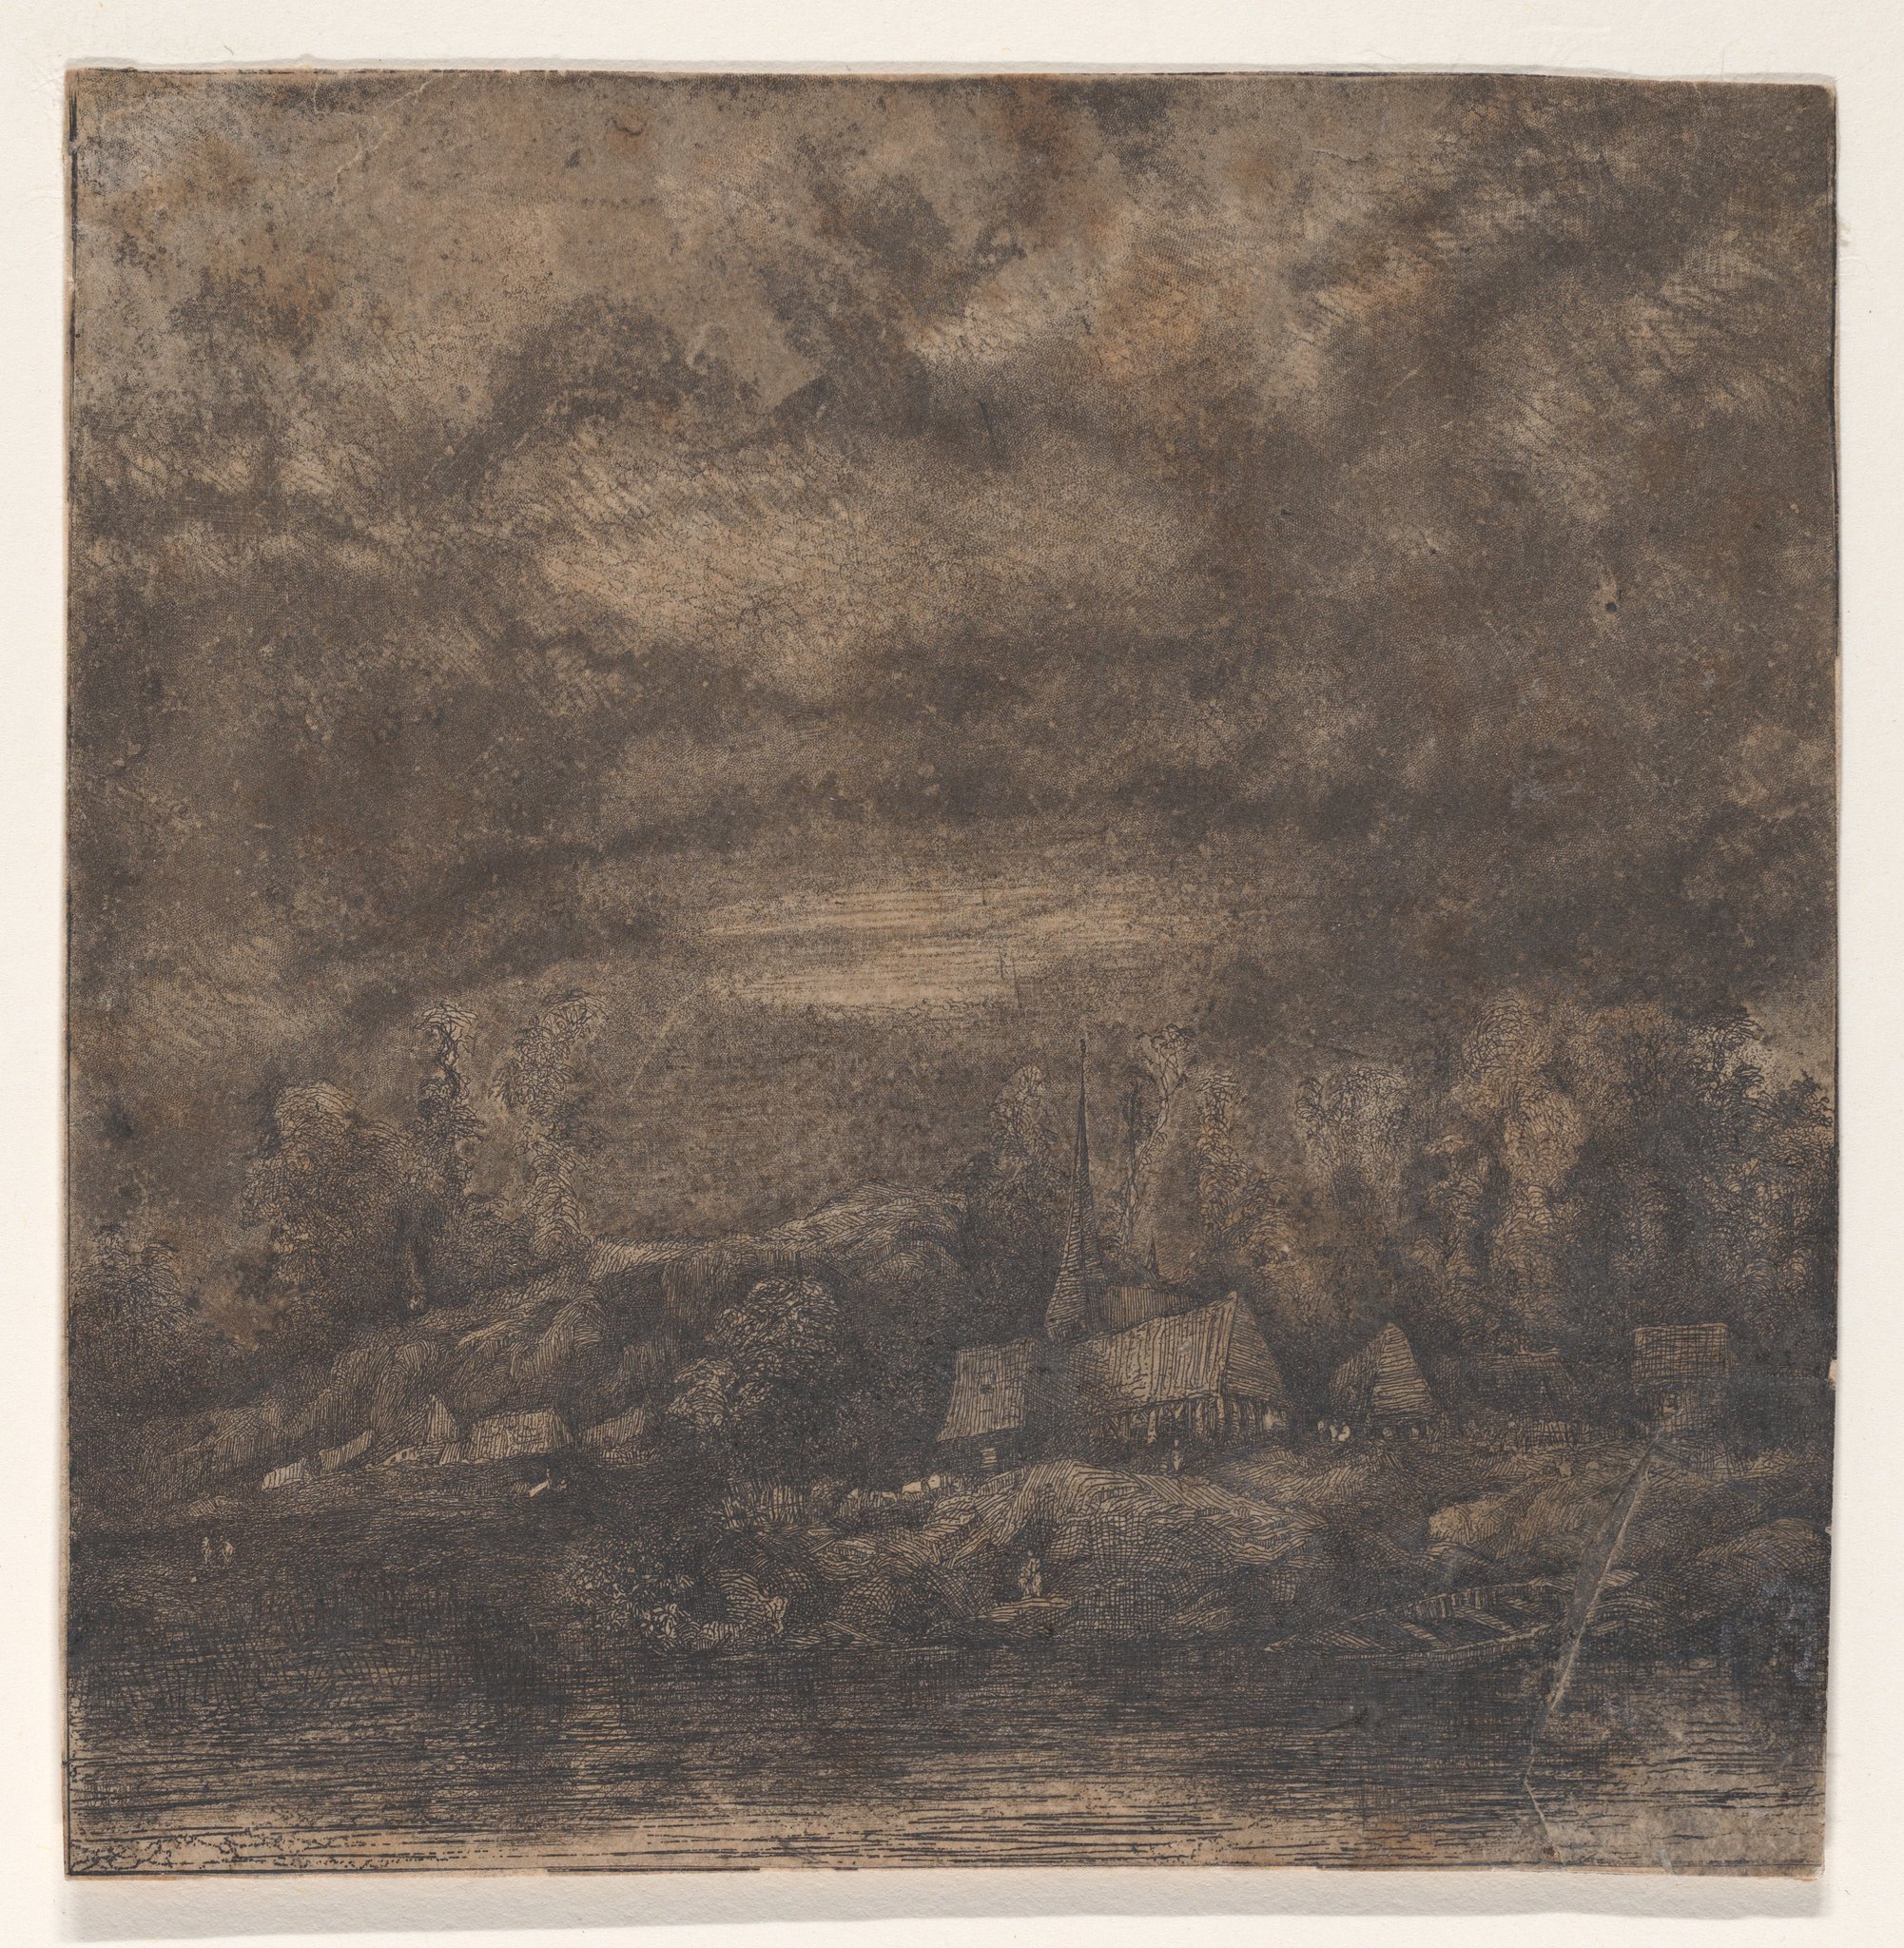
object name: print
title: Hameau de Pêcheurs (Hamlet of Fishermen)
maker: rodolphe bresdin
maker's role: artist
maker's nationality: french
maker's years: 1822-1885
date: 1849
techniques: etching